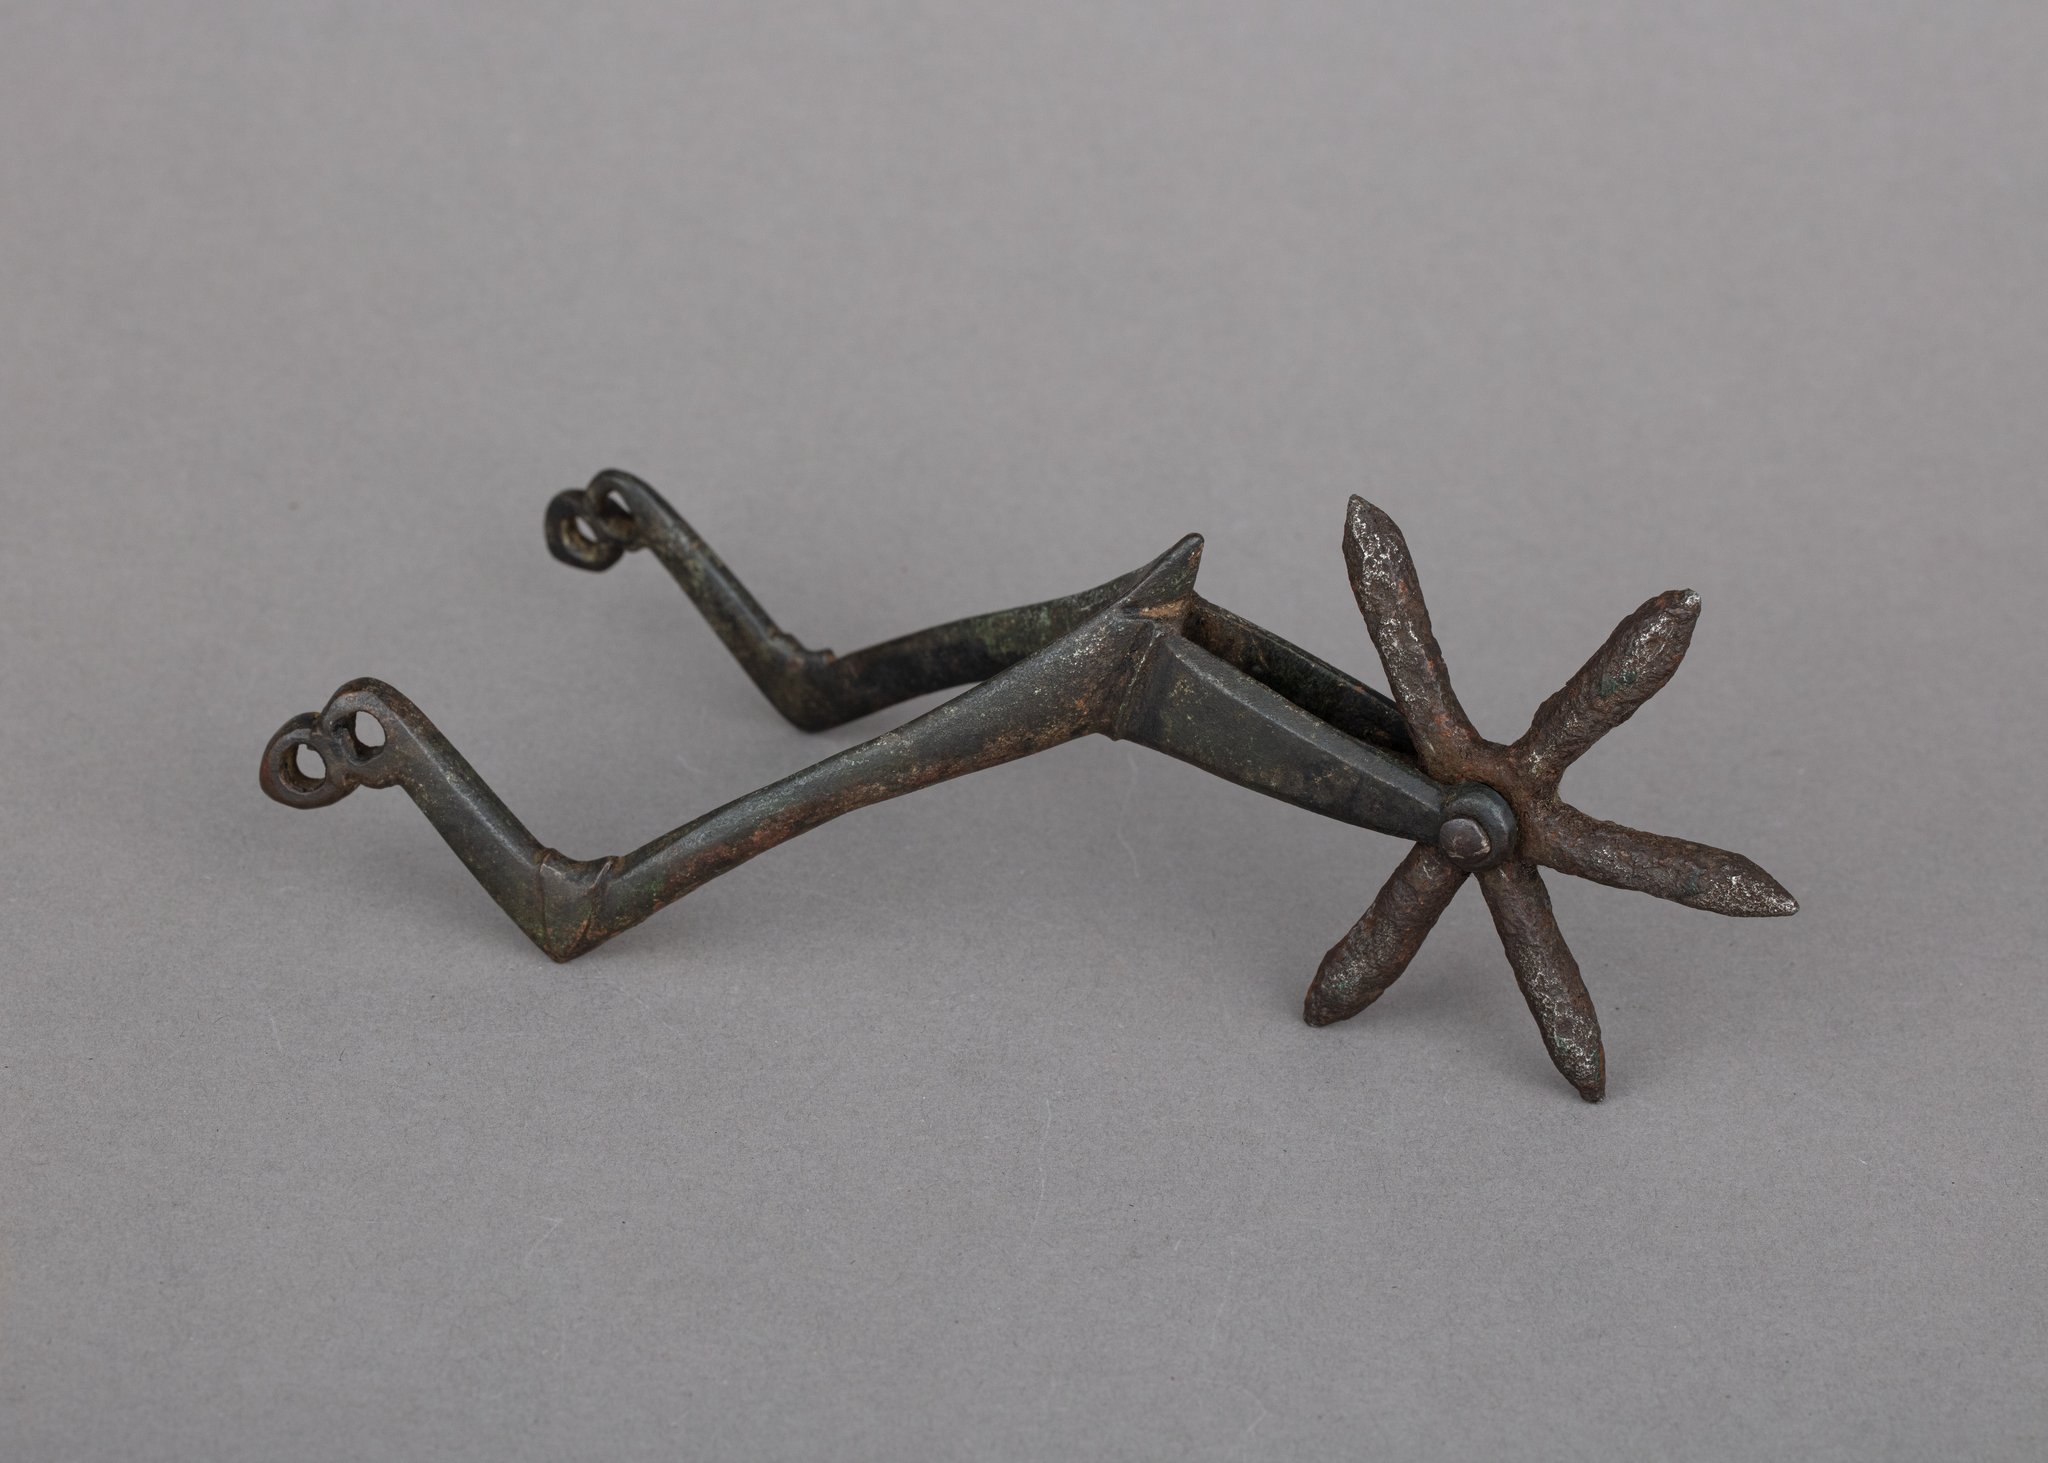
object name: spur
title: Rowel Spur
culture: european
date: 1351-1400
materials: copper alloy, iron